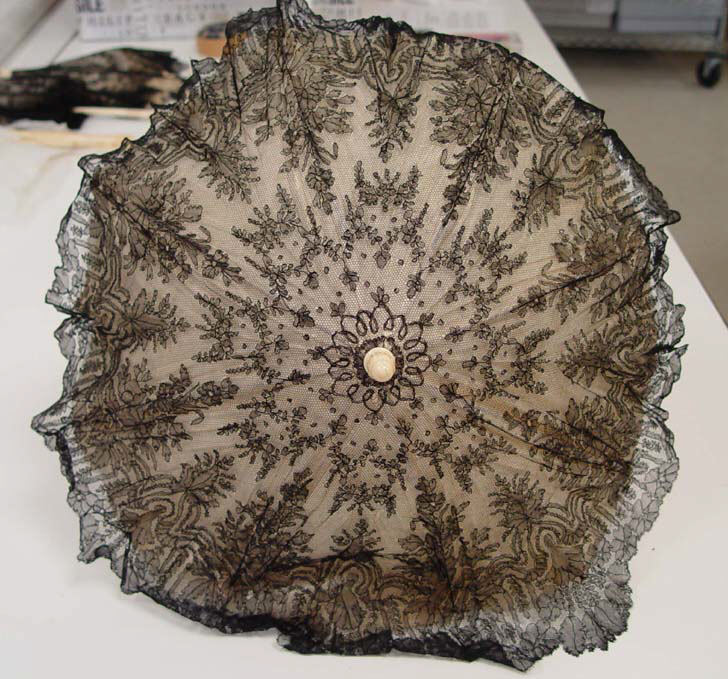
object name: parasol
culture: french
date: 1870-1880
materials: cotton, ivory, silk